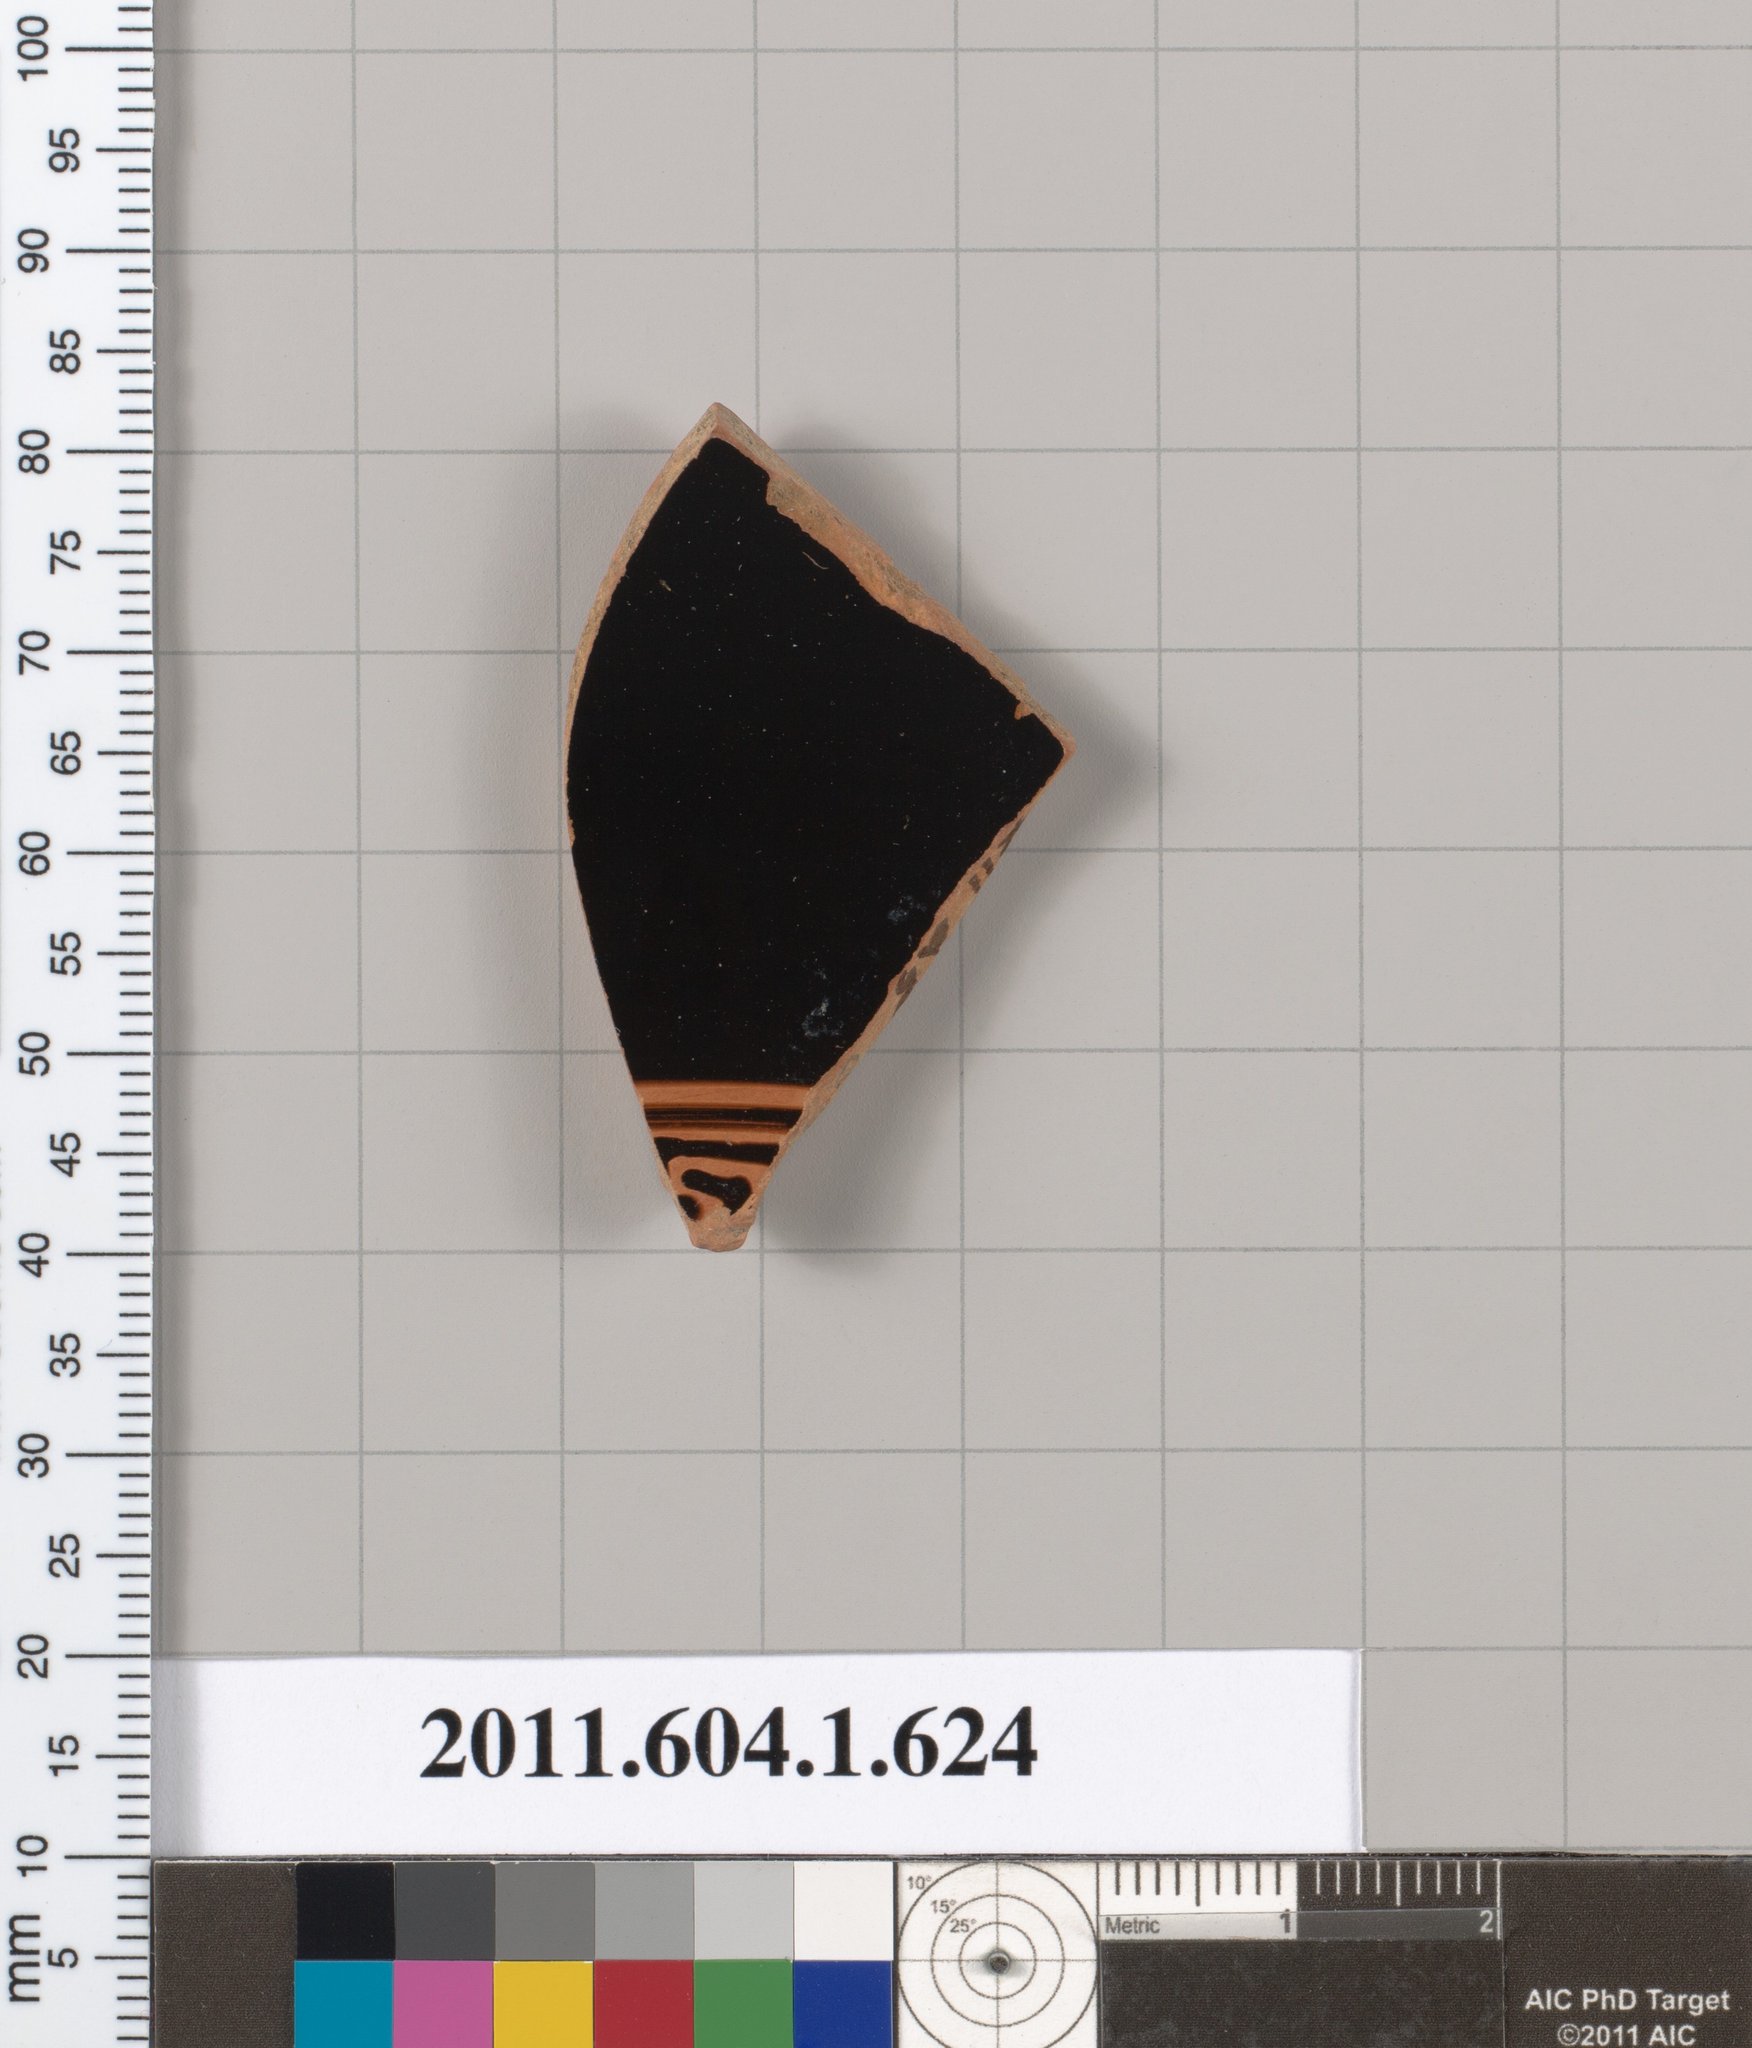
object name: kylix fragment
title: Terracotta fragment of a kylix (drinking cup)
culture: greek, attic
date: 475-451 BCE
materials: terracotta